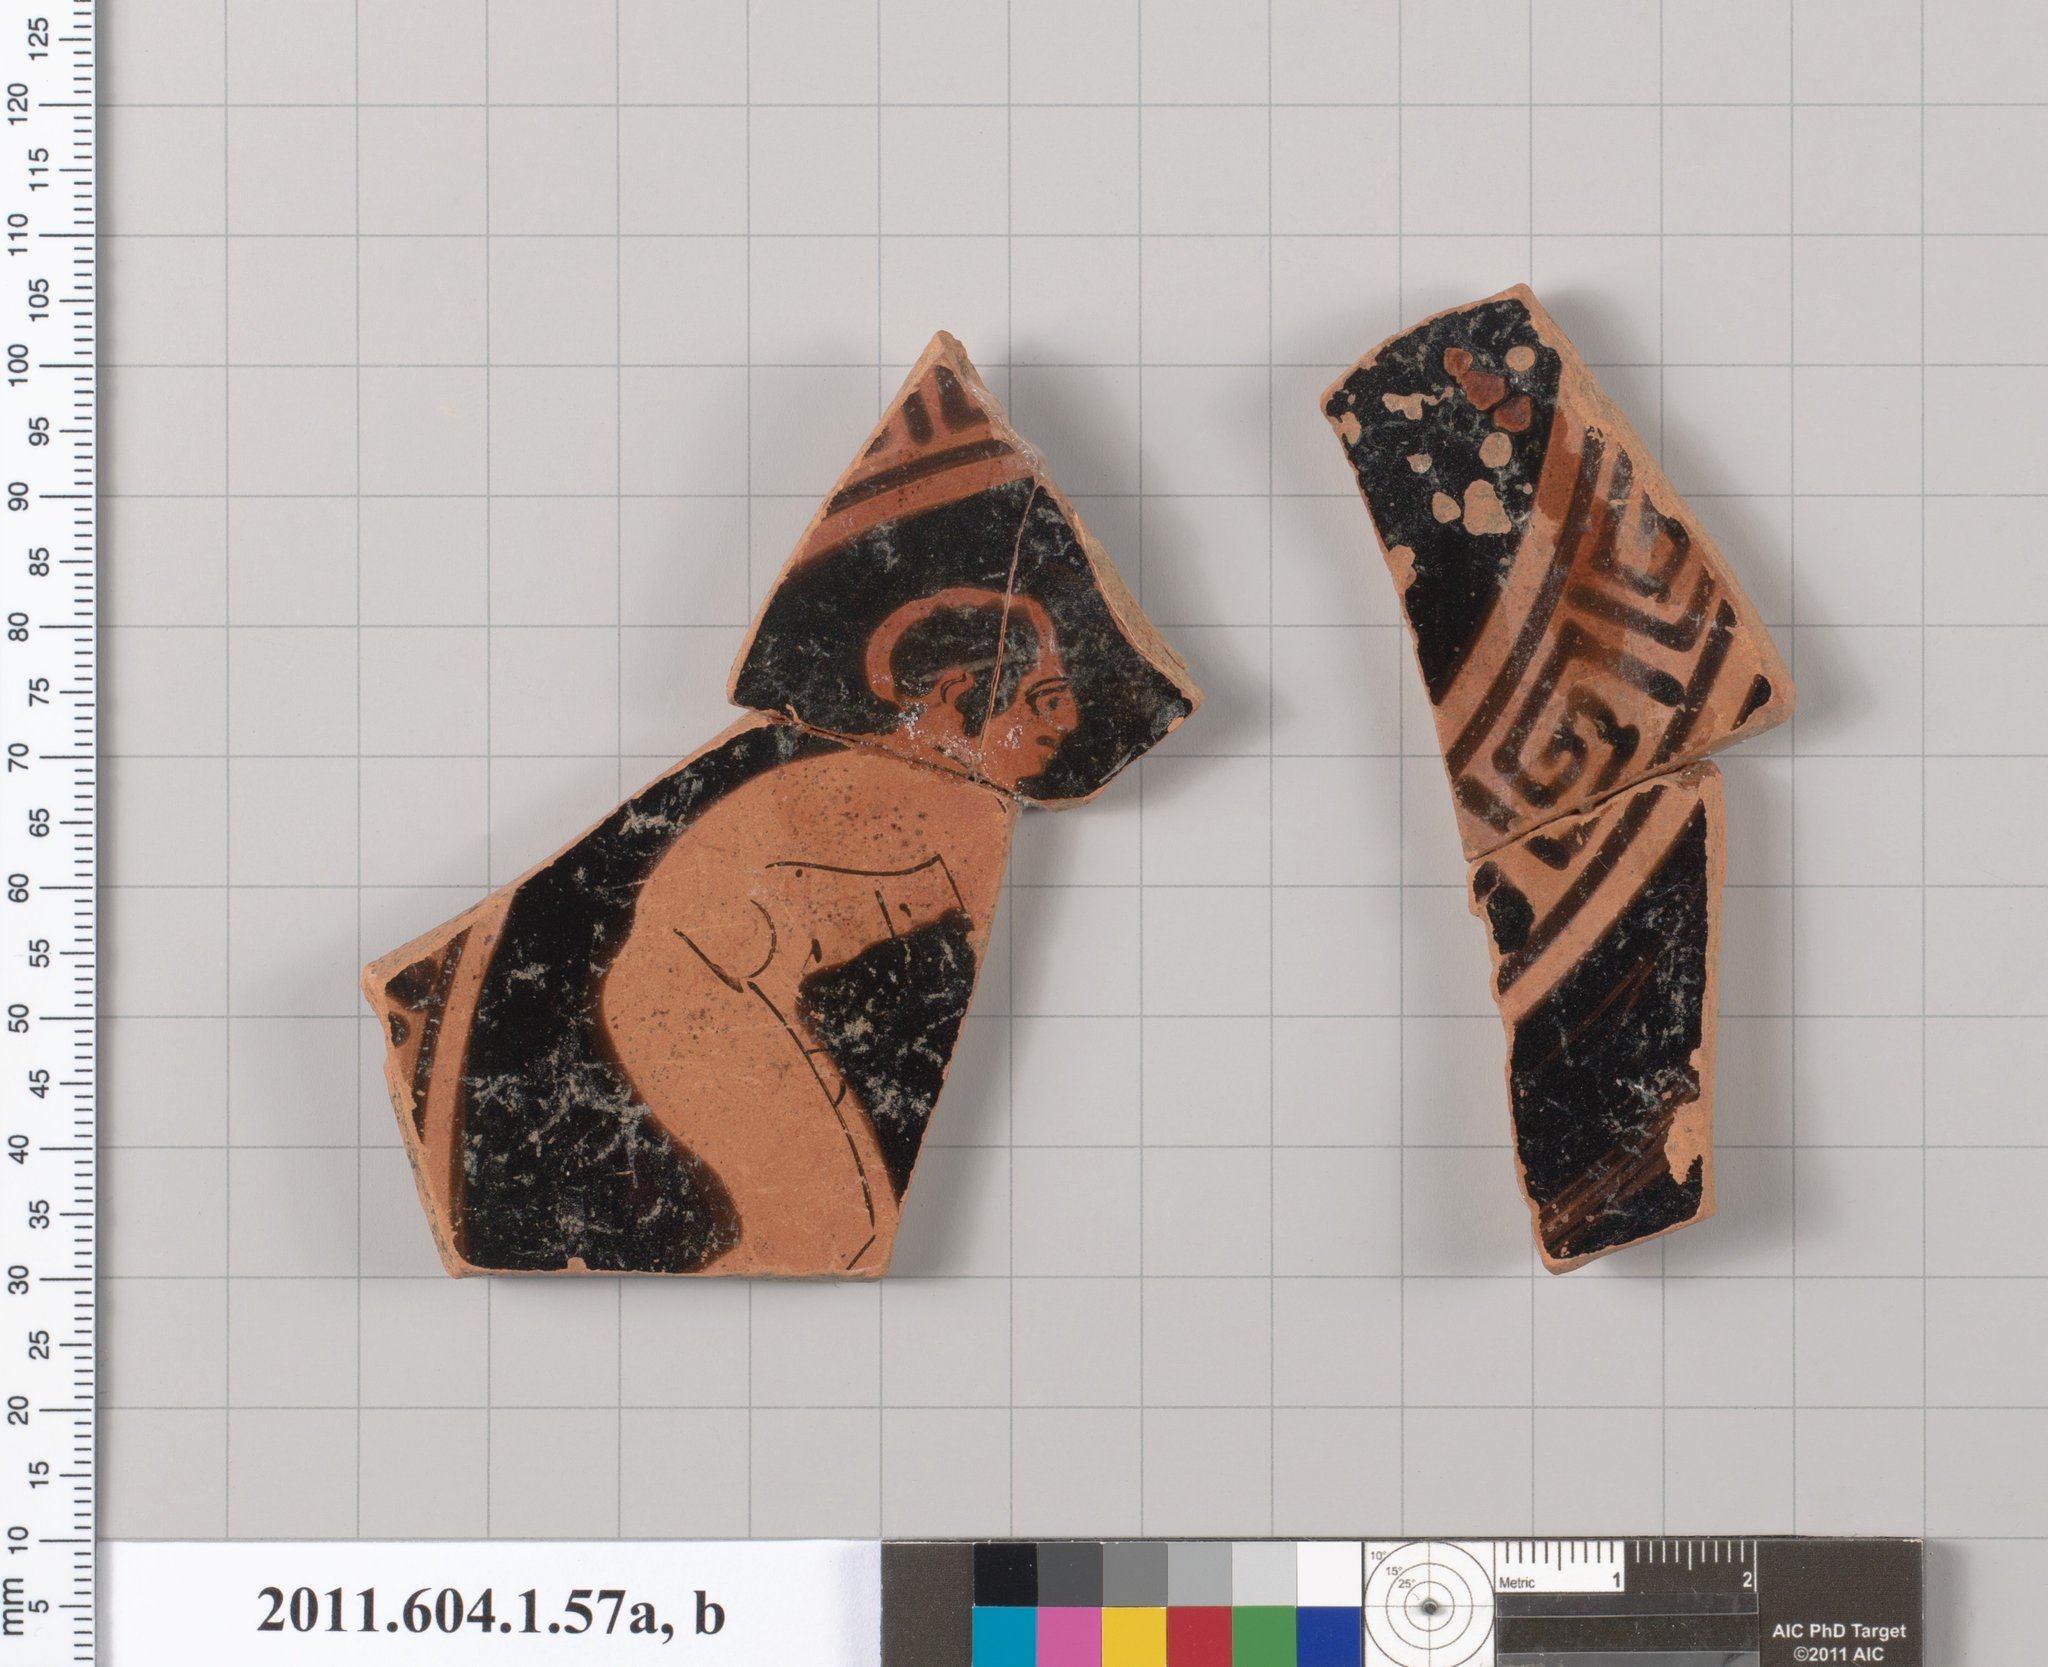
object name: kylix fragment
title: Terracotta fragments of a kylix (drinking cup)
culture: greek, attic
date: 434-401 BCE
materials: terracotta